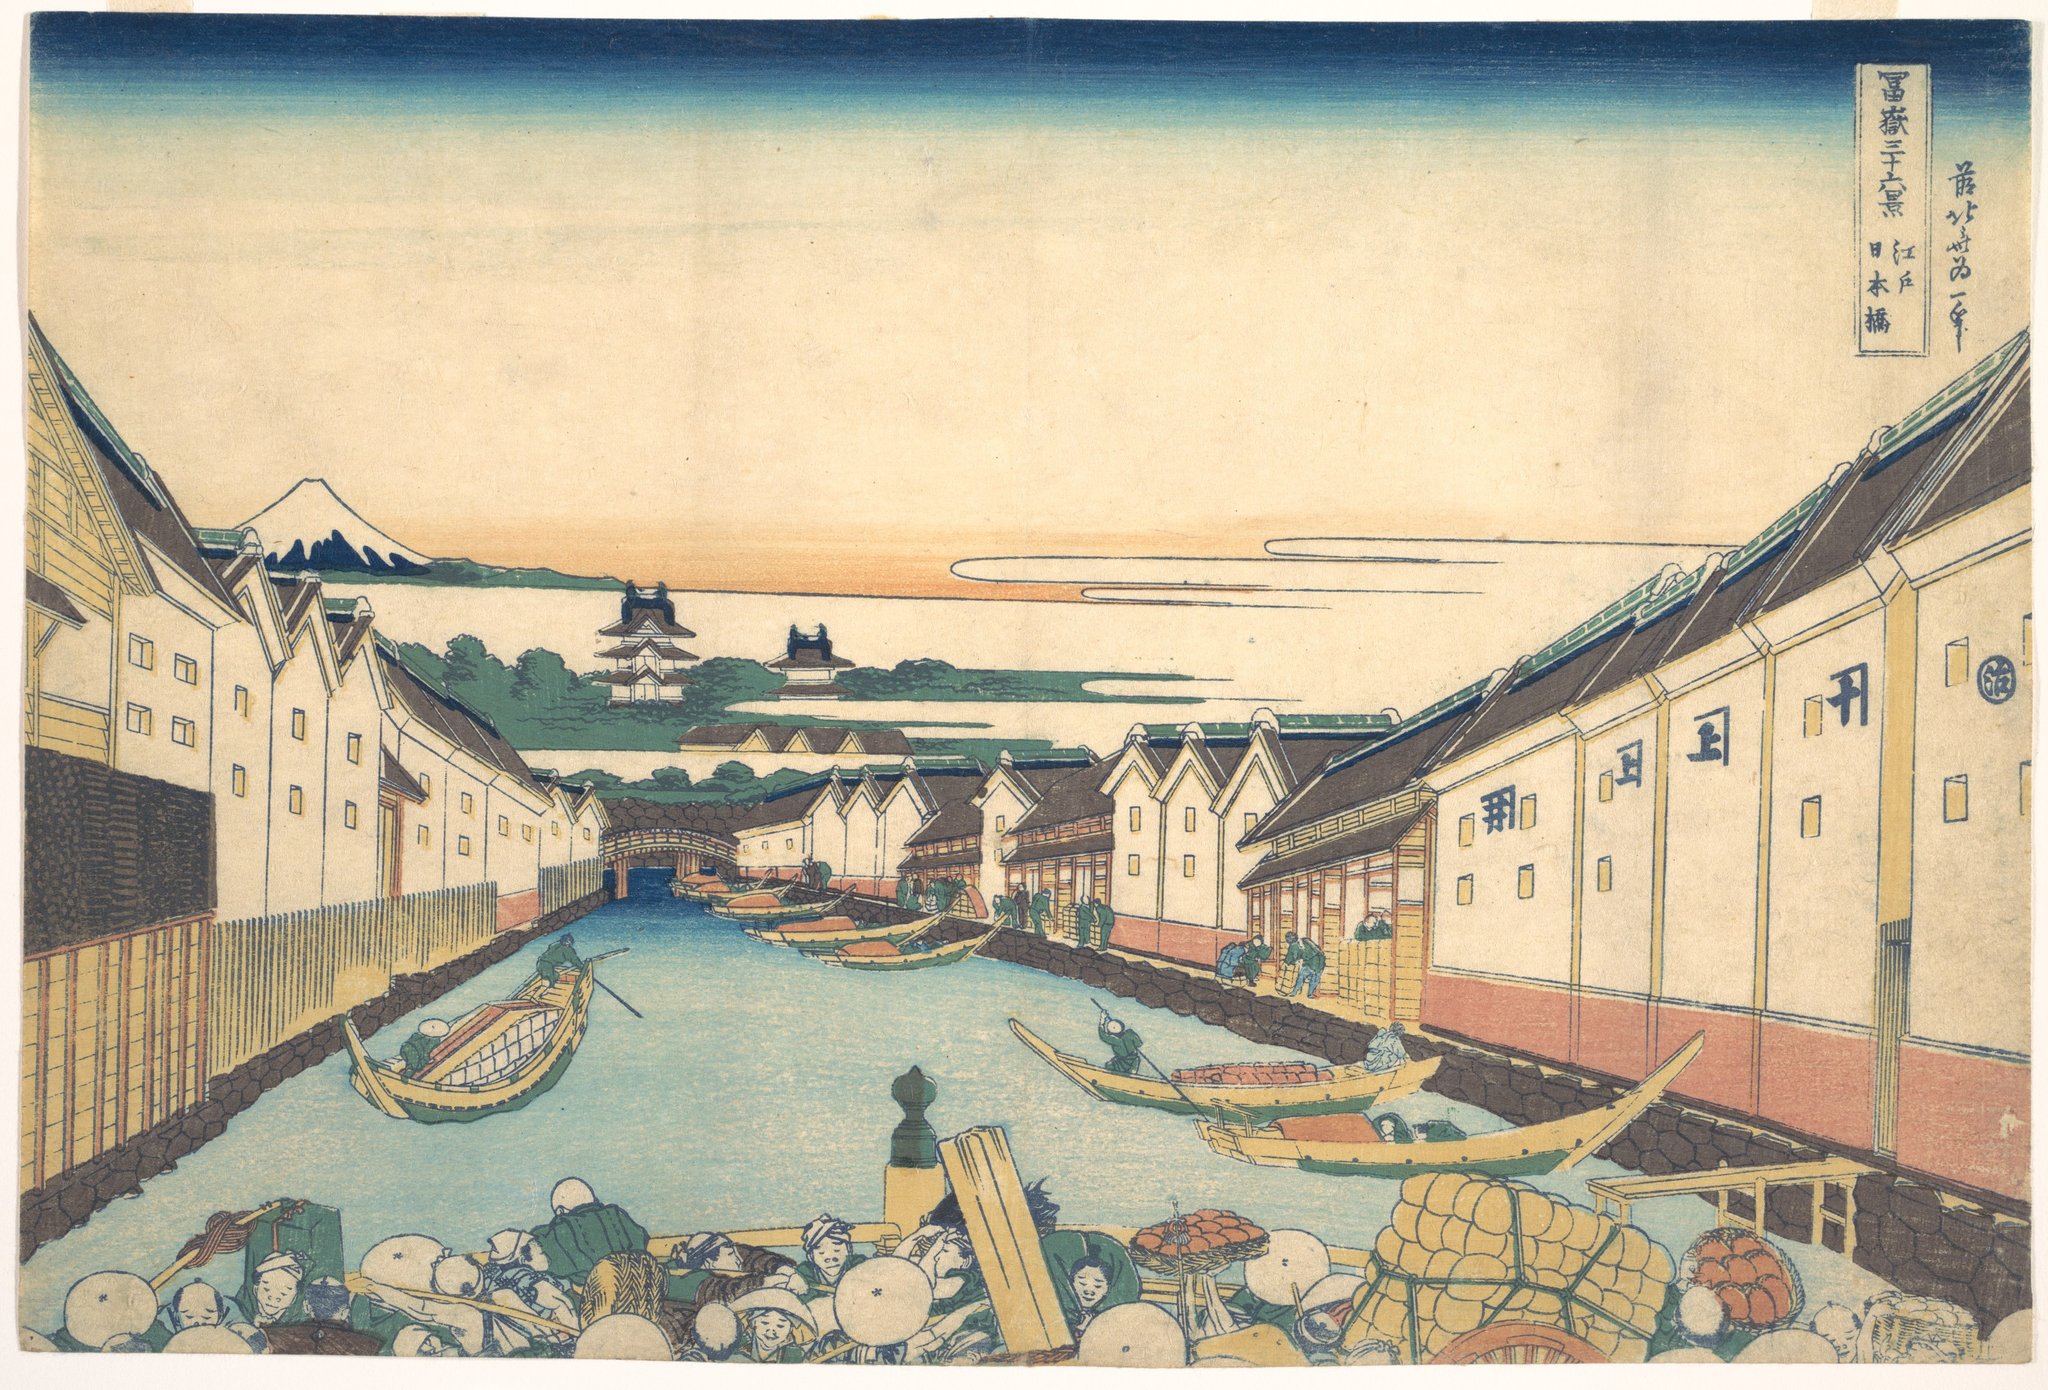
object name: woodblock print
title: Nihonbashi in Edo (Edo Nihonbashi), from the series Thirty-six Views of Mount Fuji (Fugaku sanjūrokkei)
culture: japanese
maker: katsushika hokusai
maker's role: artist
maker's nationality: japanese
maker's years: 1760-1849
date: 1830-1832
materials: ink, paper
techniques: woodblock print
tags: human figures,houses,canals,mountains,boats